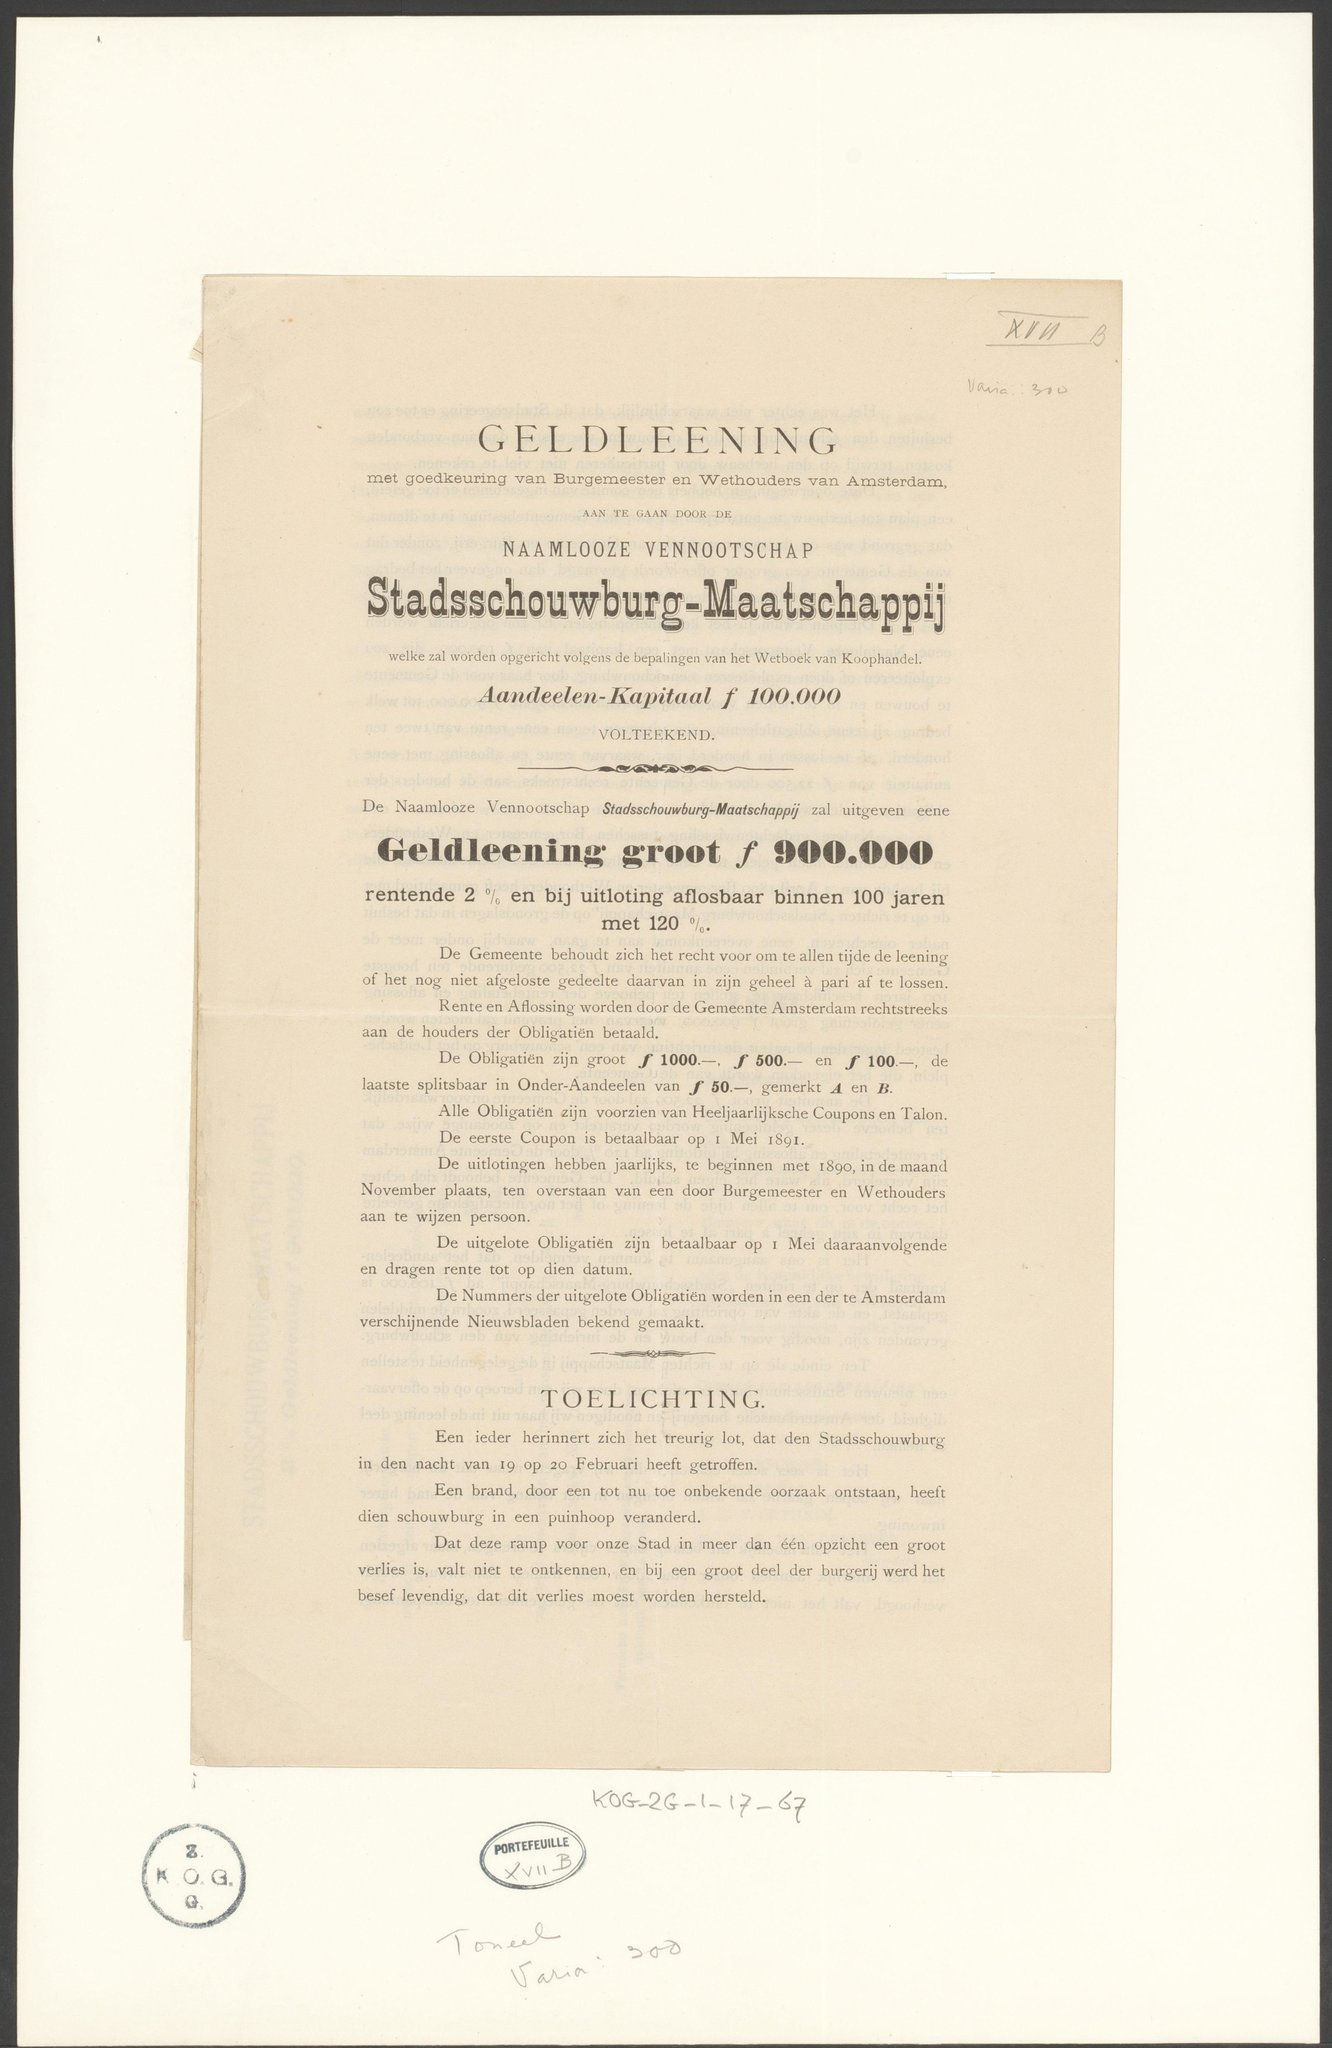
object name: text sheet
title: Aankondiging van een lening aan de Amsterdamse Schouwburg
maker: Anonymous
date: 1805-1890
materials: paper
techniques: letterpress printing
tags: on fire, ablaze, theatre, theatrical performance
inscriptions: stamp, collector's mark: Lugt 1641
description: Aankondiging van een lening aan de Amsterdamse Schouwburg ter waarde van 900.000 gulden. De lening wordt verstrekt naar aanleiding van de schade die de brand op 19 en 20 februari 1890 heeft veroorzaakt. De ontvanger van de aankondiging kan door middel van obligaties deelnemen aan de lening en ontvangt dan een rente van 2%. Bijgevoegd een antwoordkaart waarmee de ontvanger zich kan inkopen in de lening. Onderwerpsrubrieken binnen de Atlas Zeden en Gewoonten: Tooneel, Varia (Beheer en financiën).